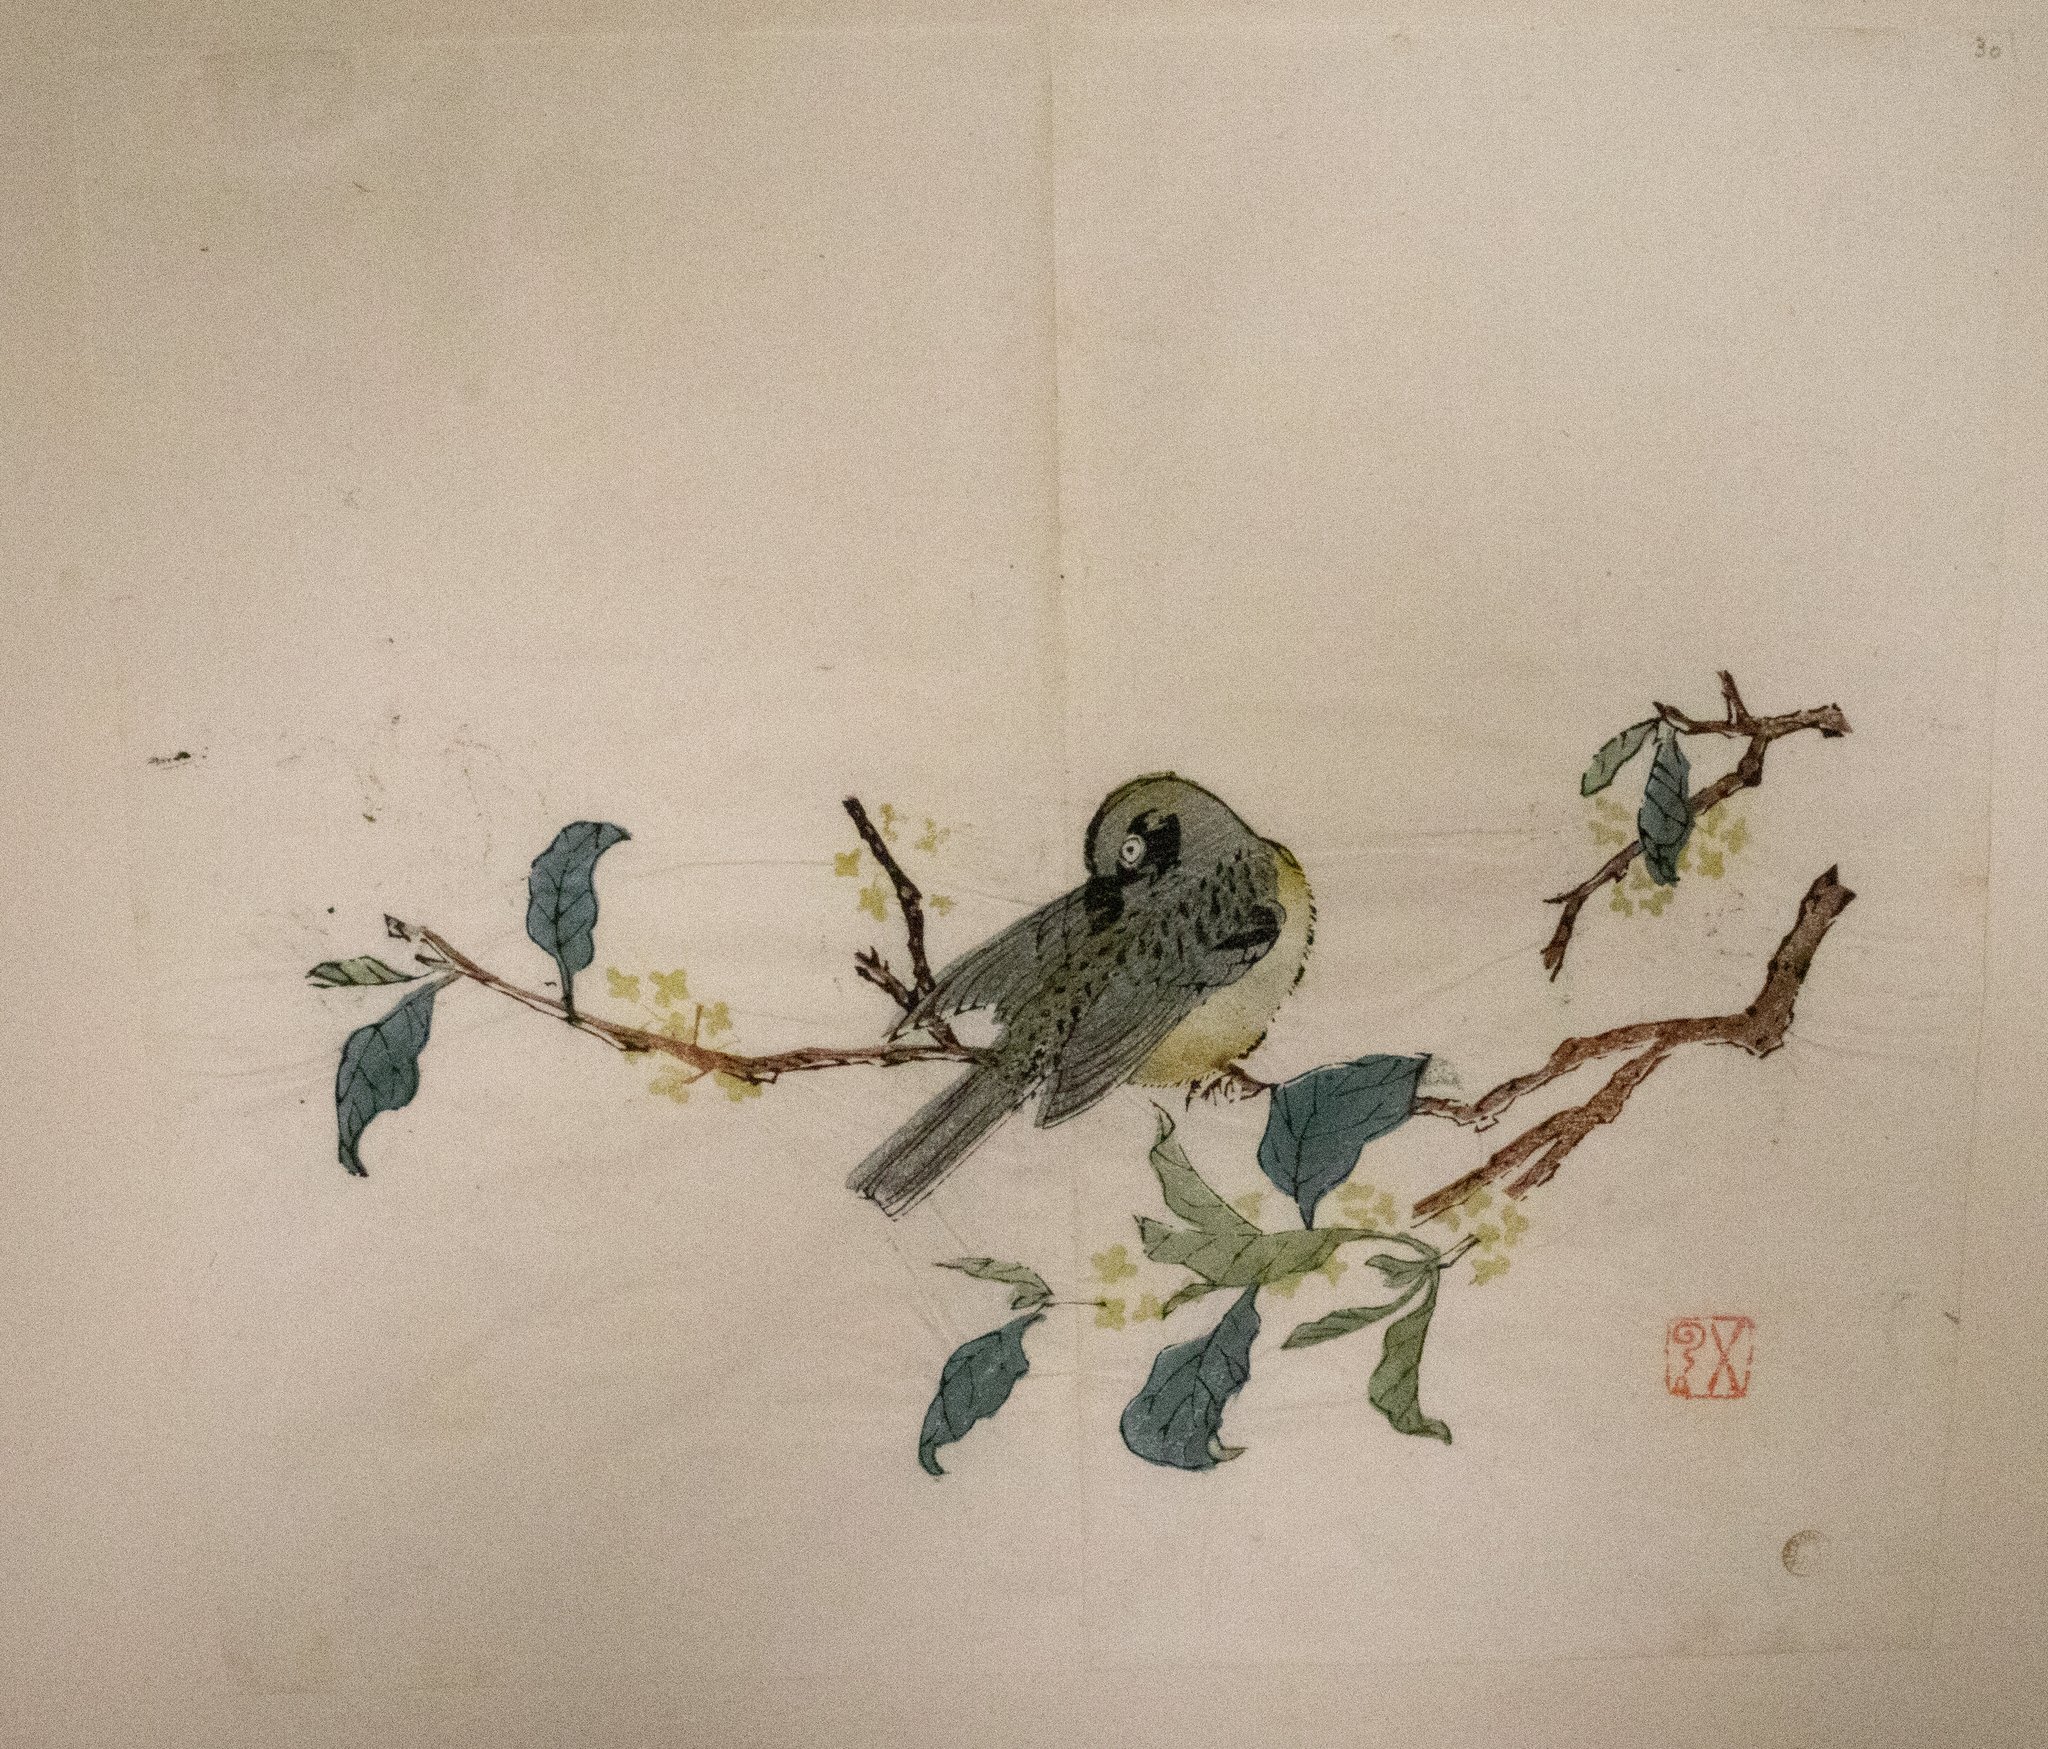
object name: print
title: Page from Shi Zhu Zhai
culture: chinese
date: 1736-1795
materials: ink, paper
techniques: polychrome, woodblock print